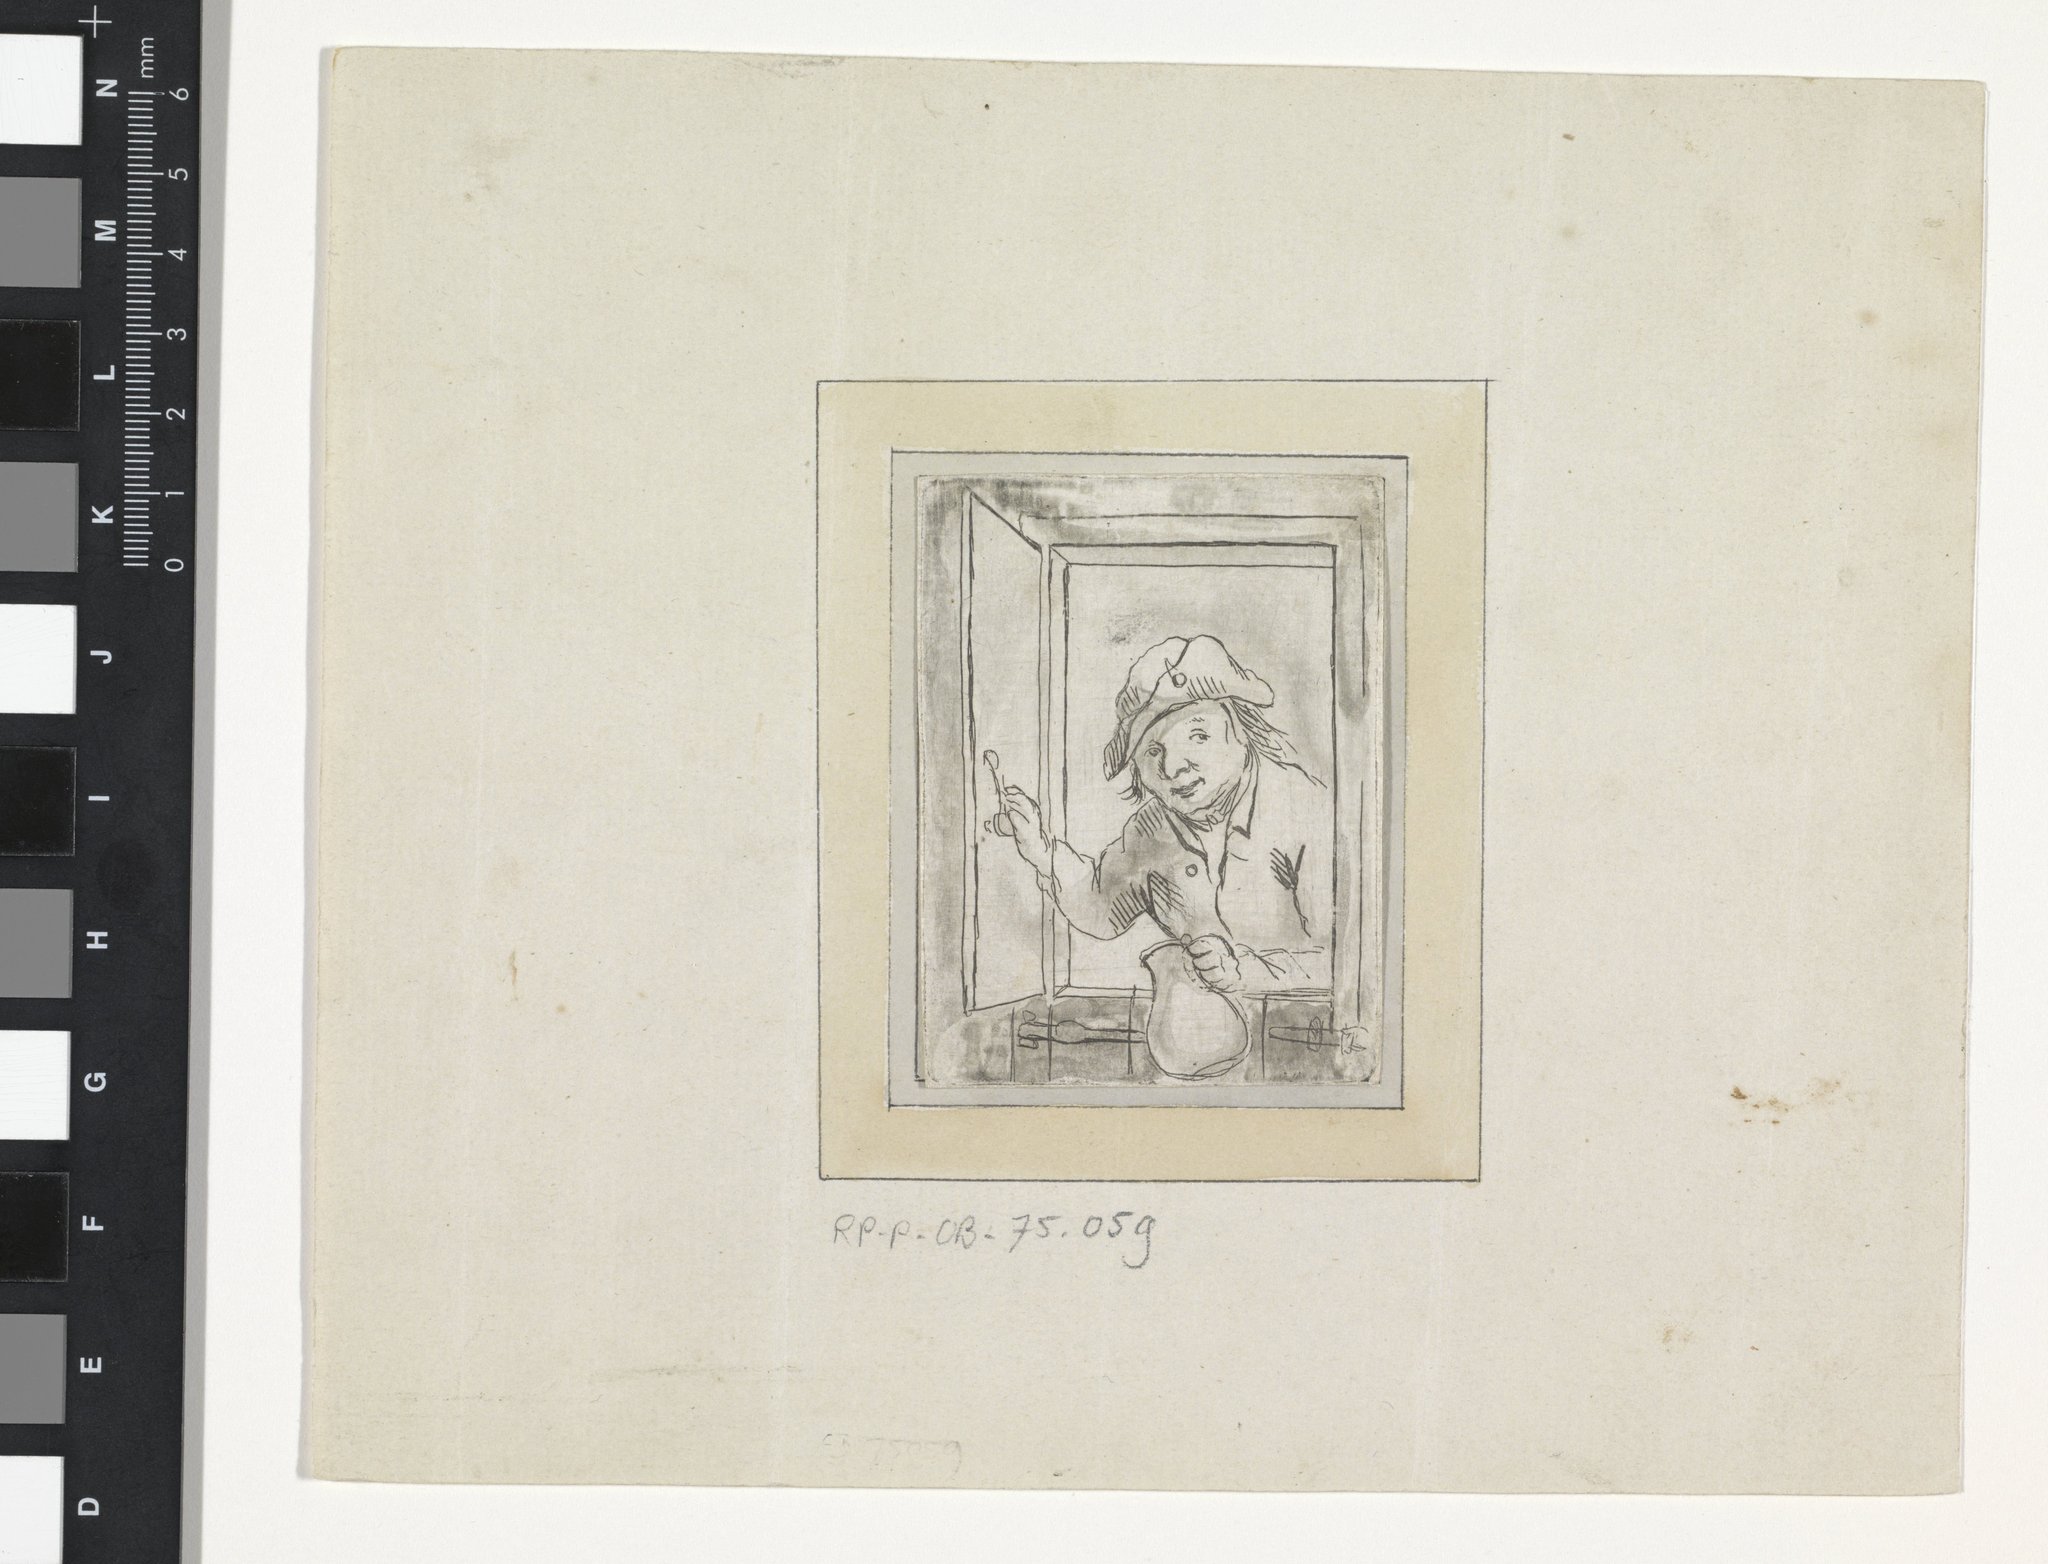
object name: print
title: Man met kruik in open raam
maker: Anonymous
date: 1700-1800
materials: paper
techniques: aquatint, etching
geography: netherlands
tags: human figure at (open) window, seen from outside